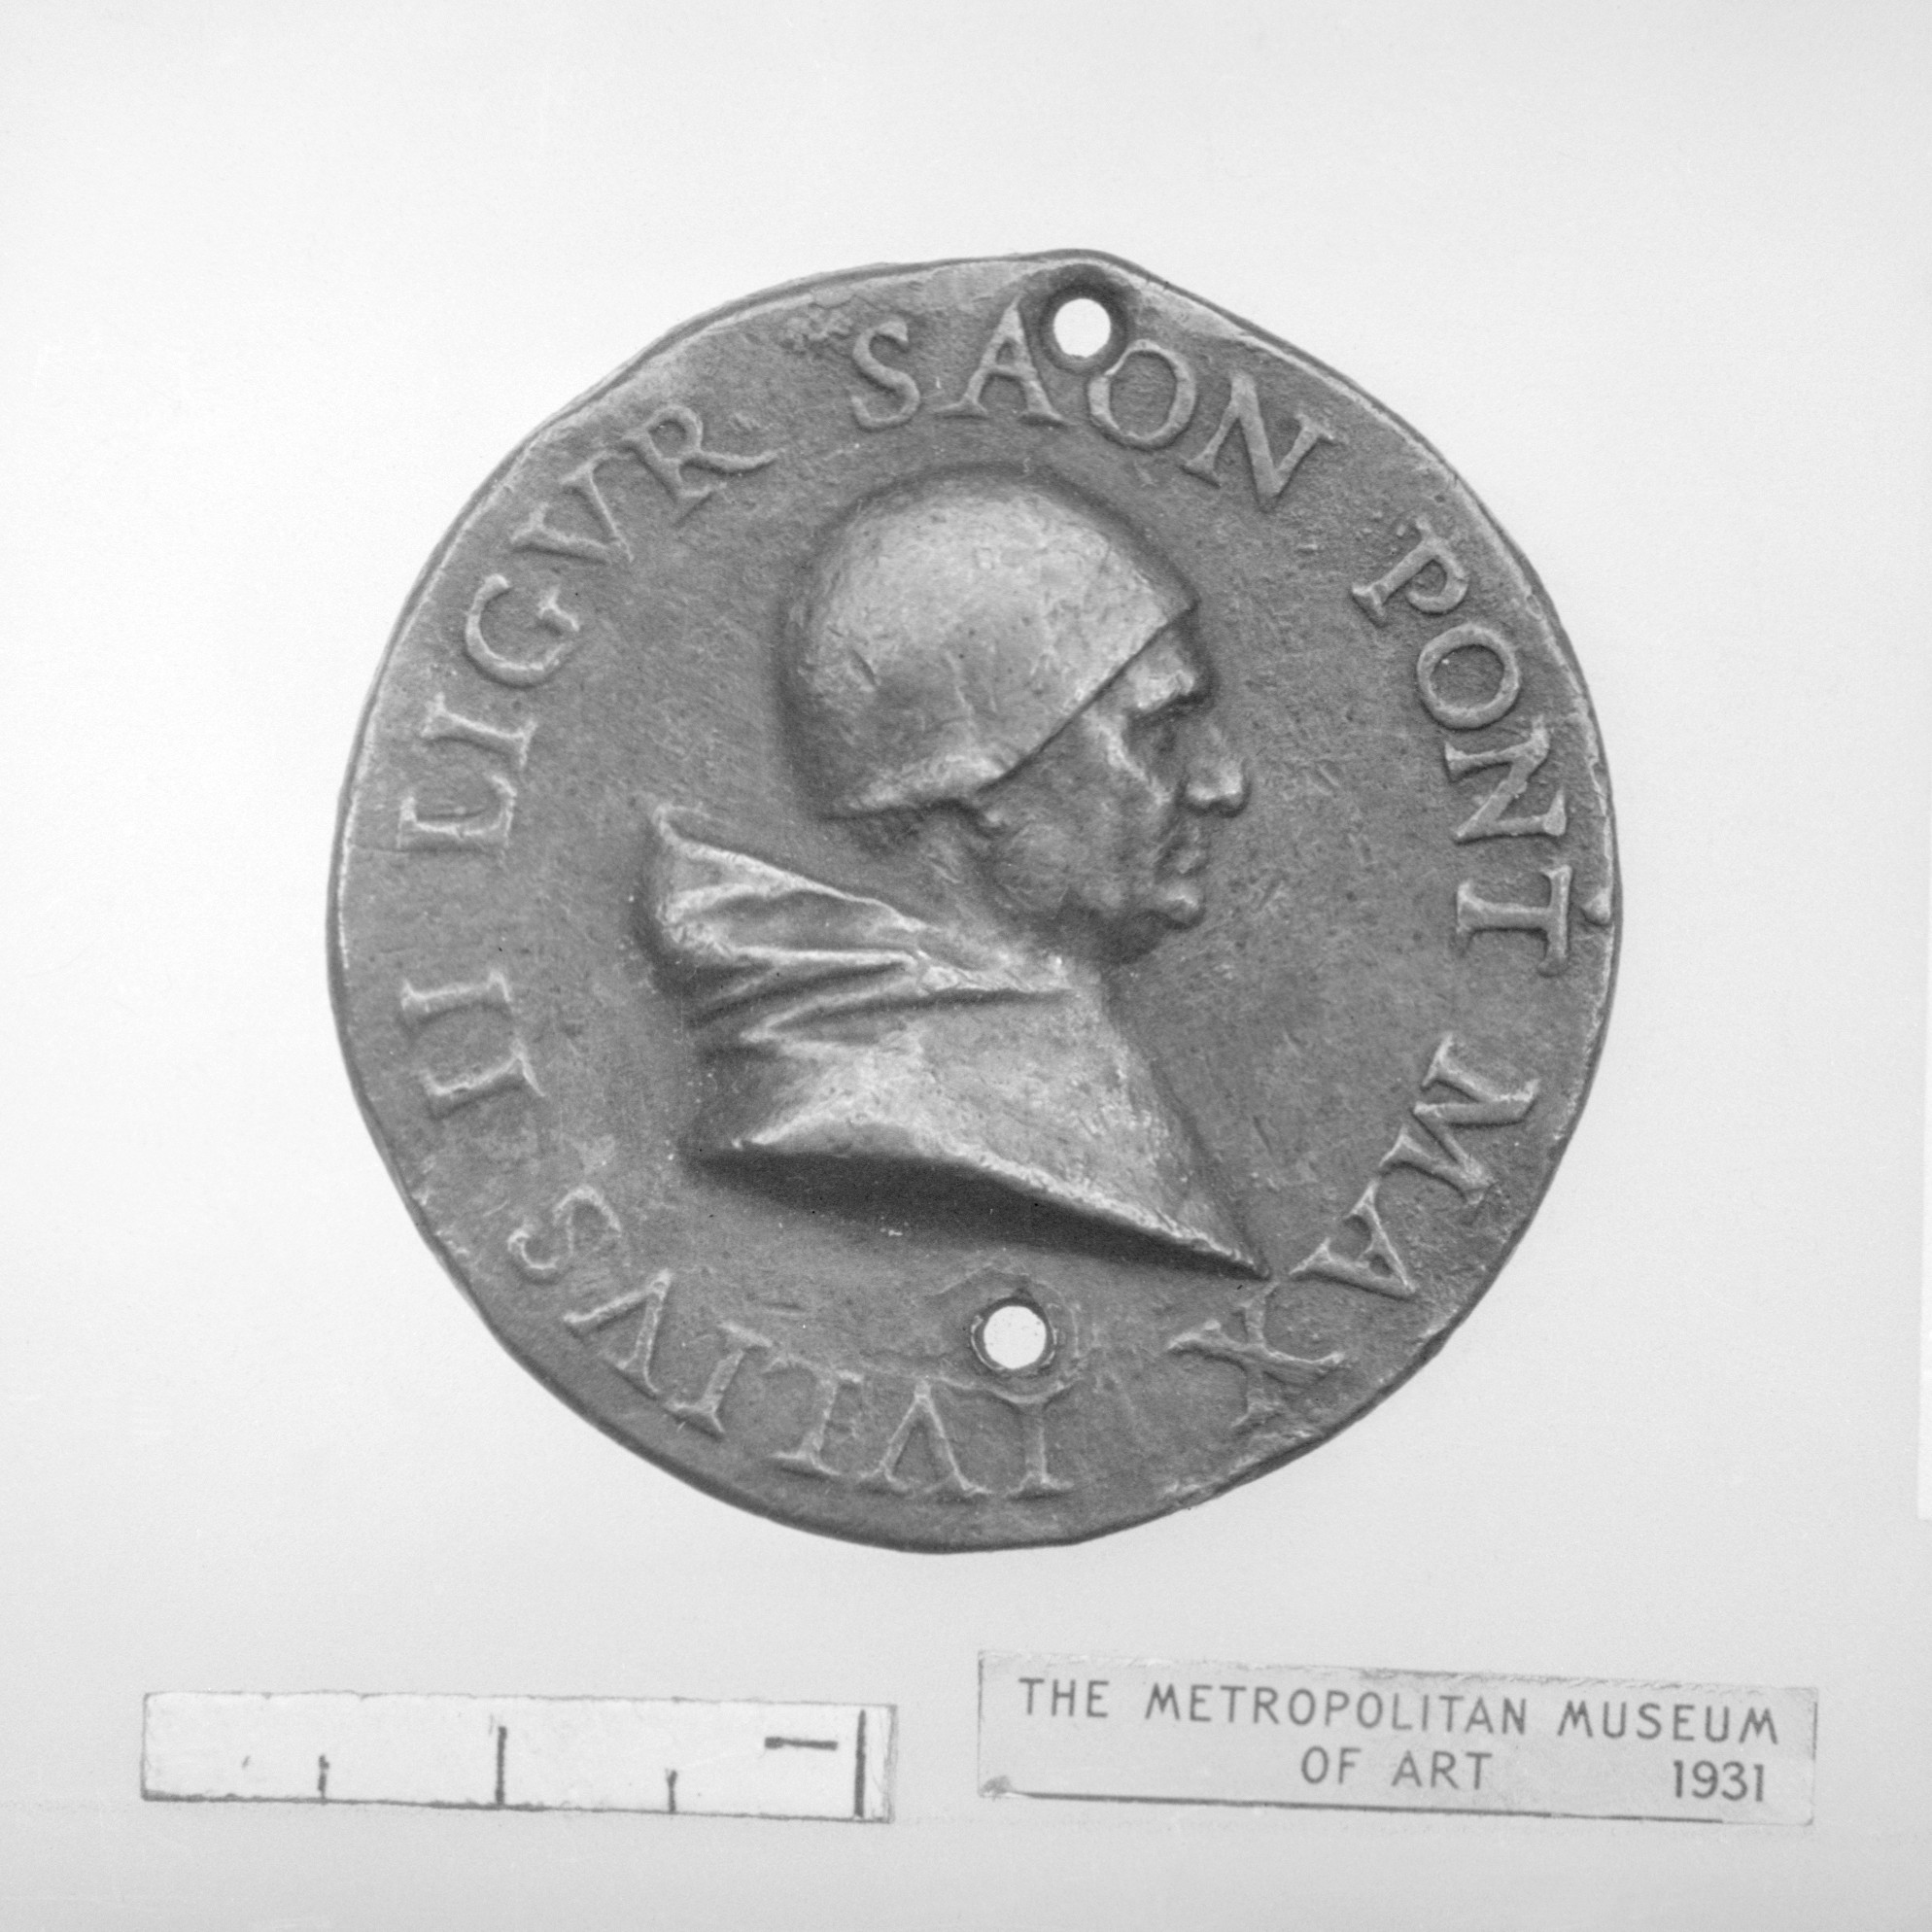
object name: medal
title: Julius II (Pope, 1503–15)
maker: gian cristoforo romano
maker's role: artist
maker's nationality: italian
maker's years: 1465-1512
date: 1504-1505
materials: bronze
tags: women,popes